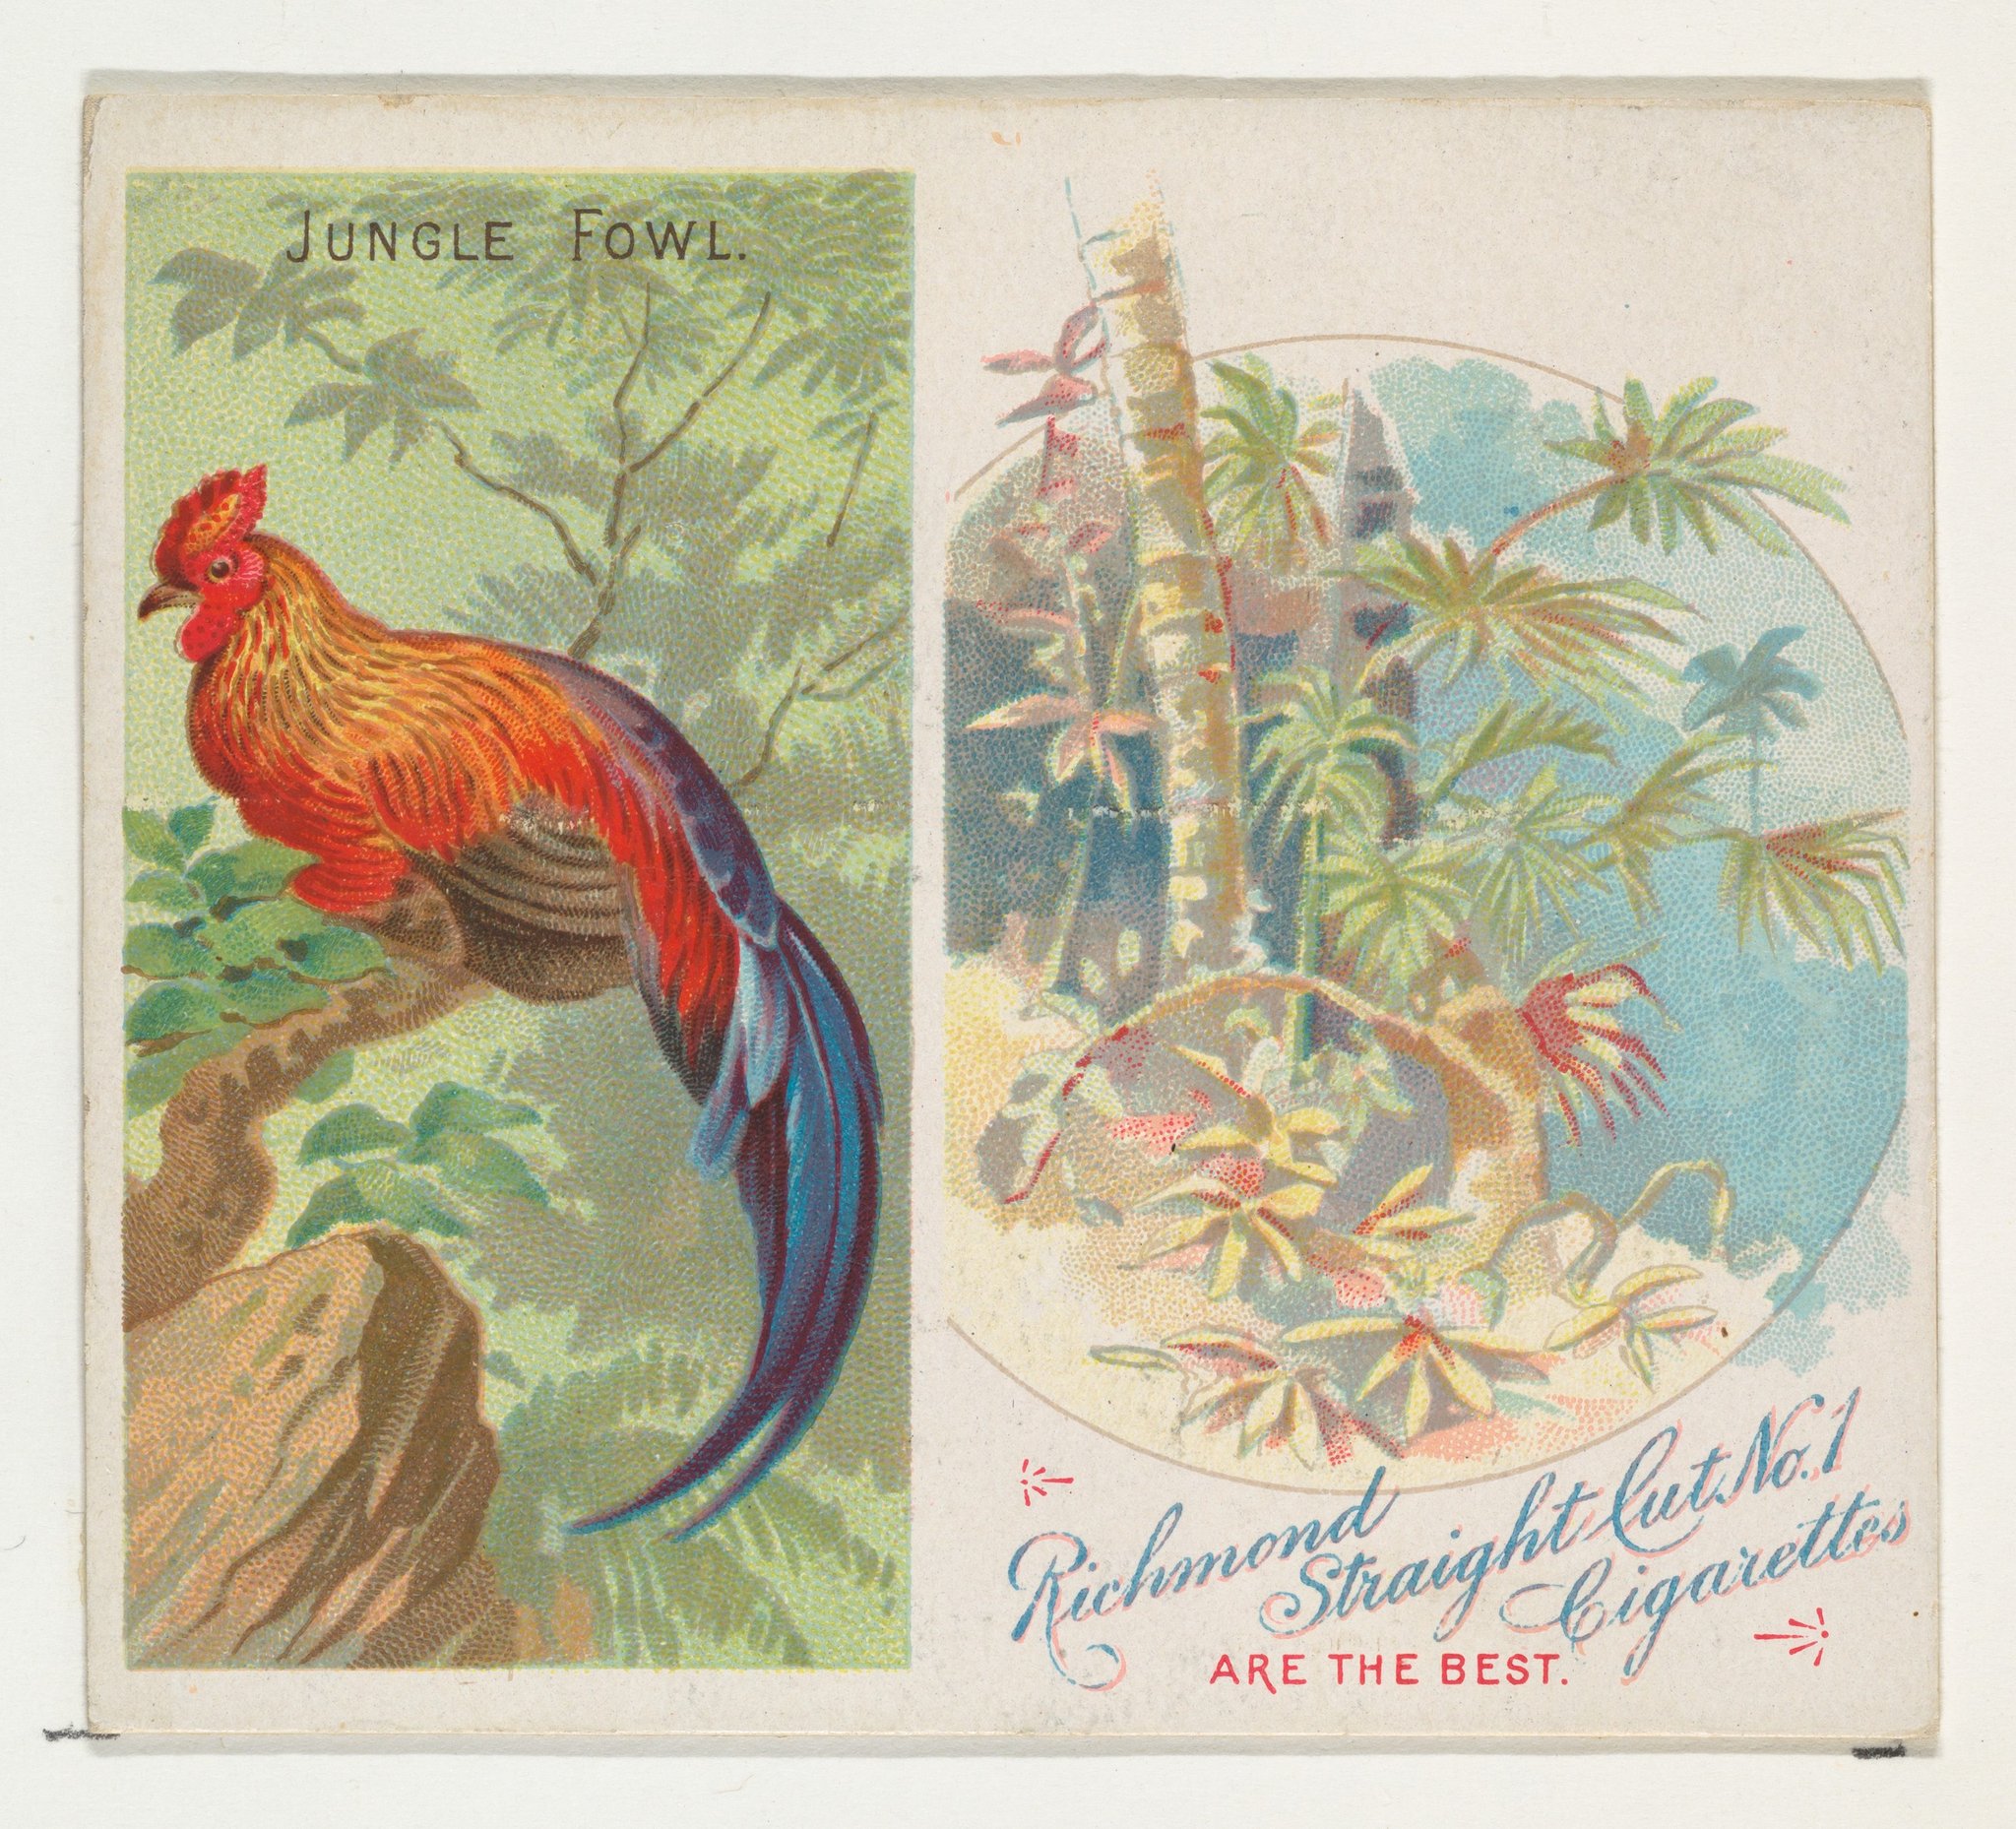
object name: print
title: Jungle Fowl, from Birds of the Tropics series (N38) for Allen & Ginter Cigarettes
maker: allen & ginter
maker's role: publisher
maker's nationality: american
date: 1889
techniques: color lithograph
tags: birds